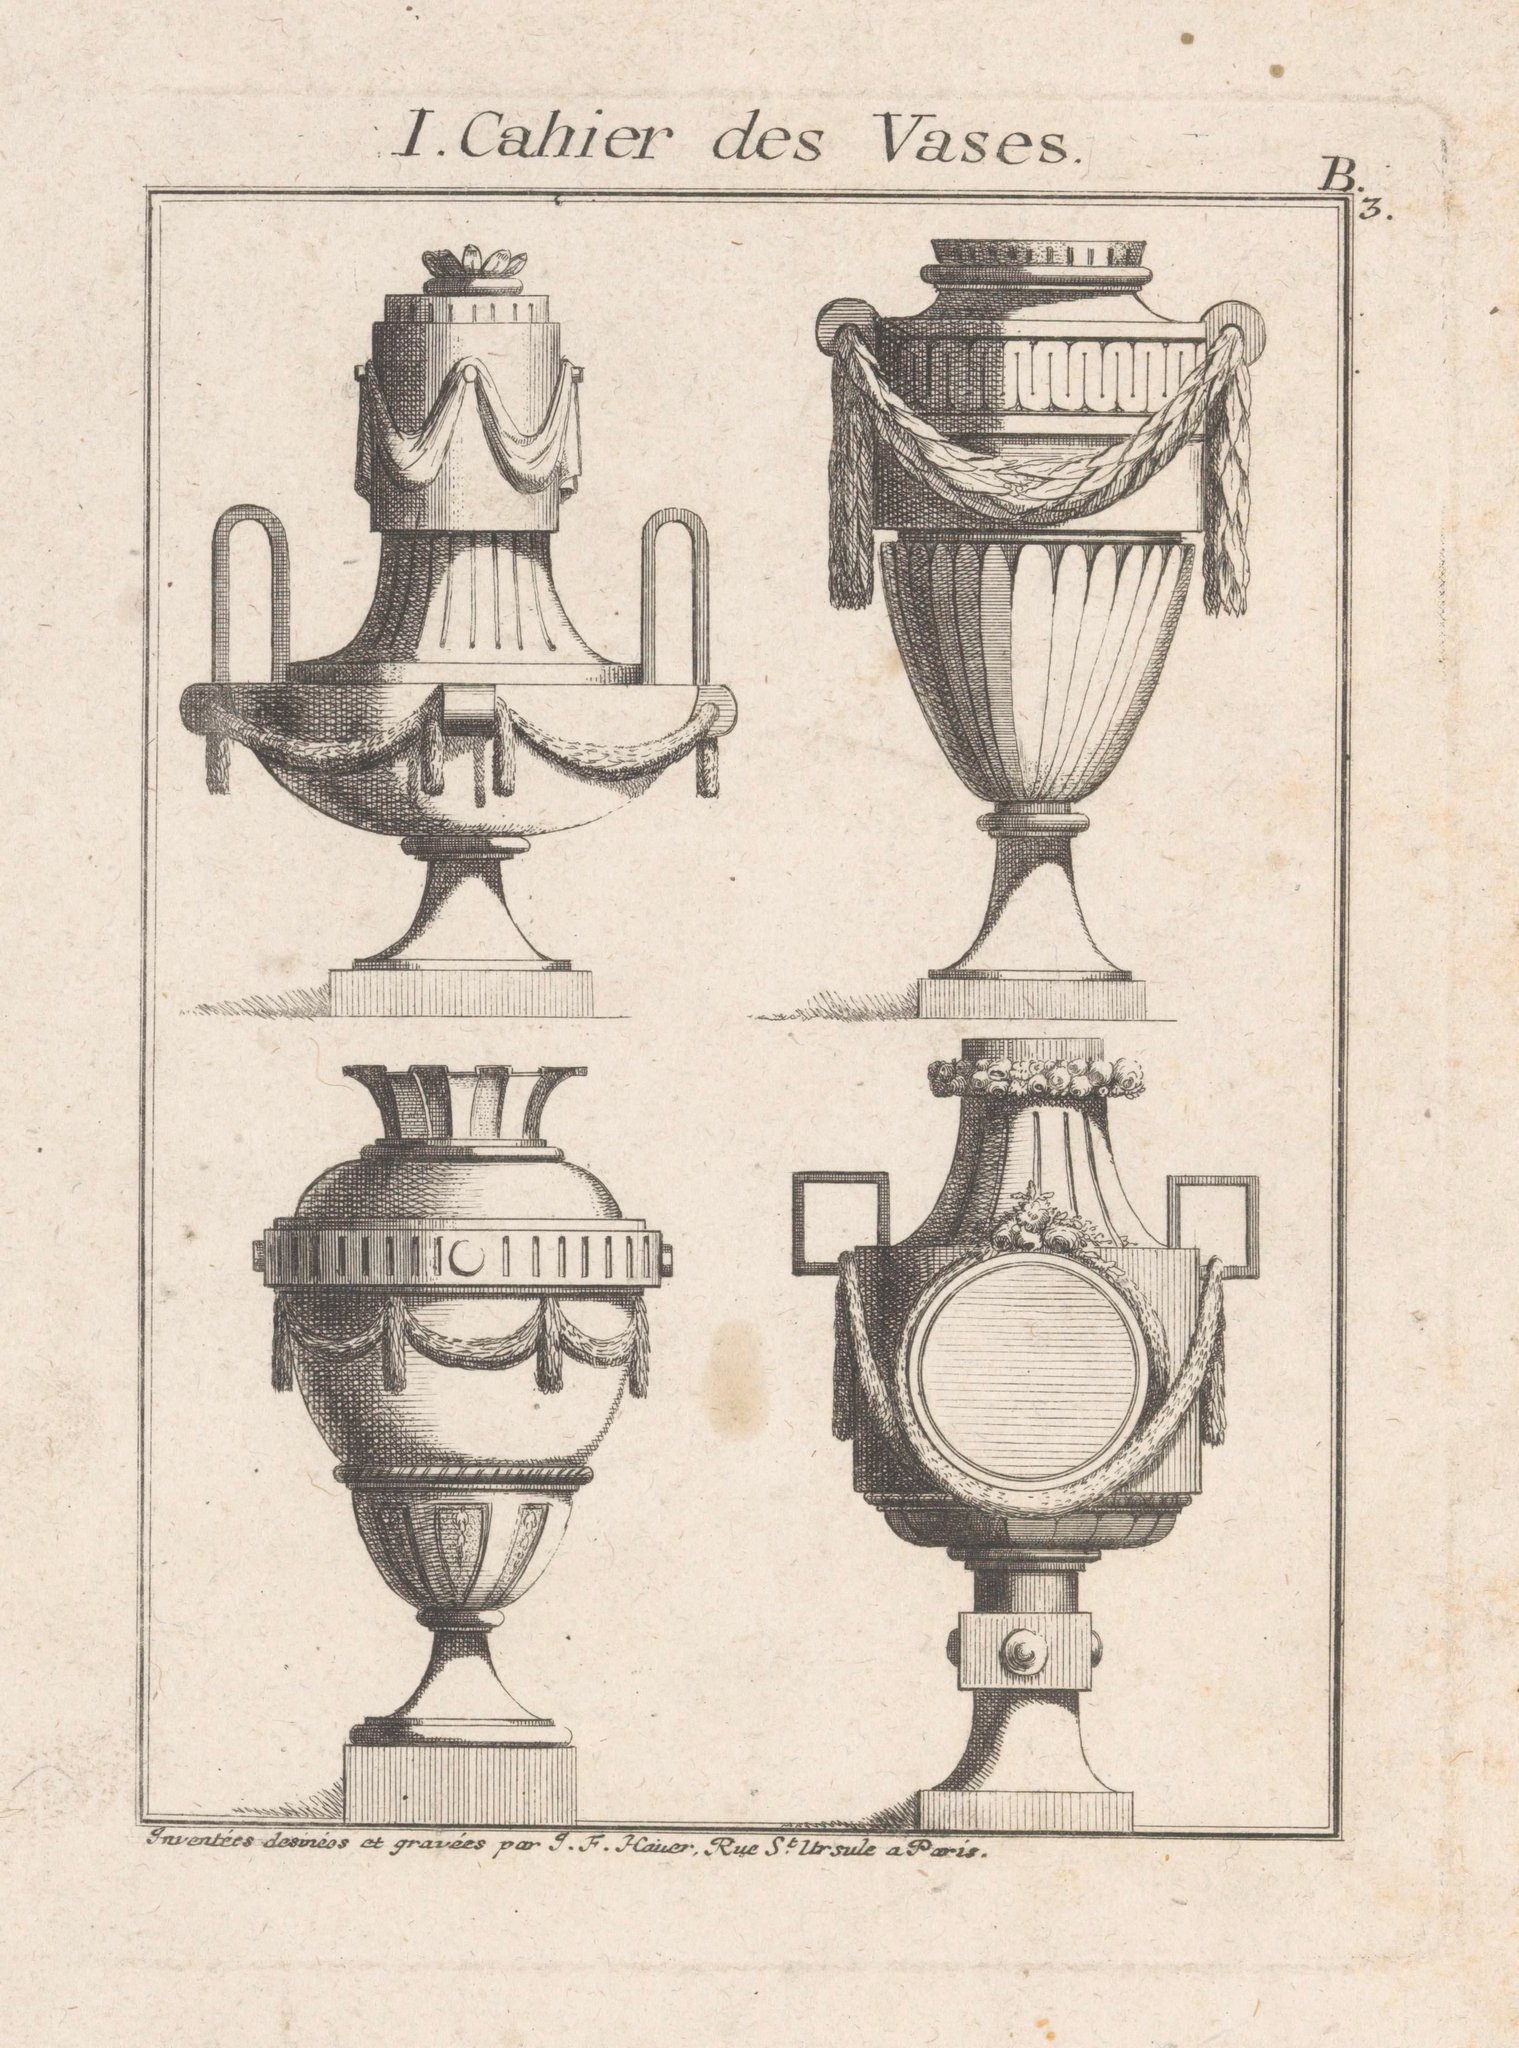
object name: print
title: I Cahier des Vases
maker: johann thomas hauer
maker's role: print maker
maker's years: 1748-1820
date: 1781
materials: paper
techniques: engraving, etching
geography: paris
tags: vase ~ ornament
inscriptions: collector's mark: Lugt 2760, collector's mark: Lugt 2228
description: Ontwerpen voor vier vazen met bloemen, guirlandes en ornamenten. De vazen links boven en rechts onder hebben twee oren.